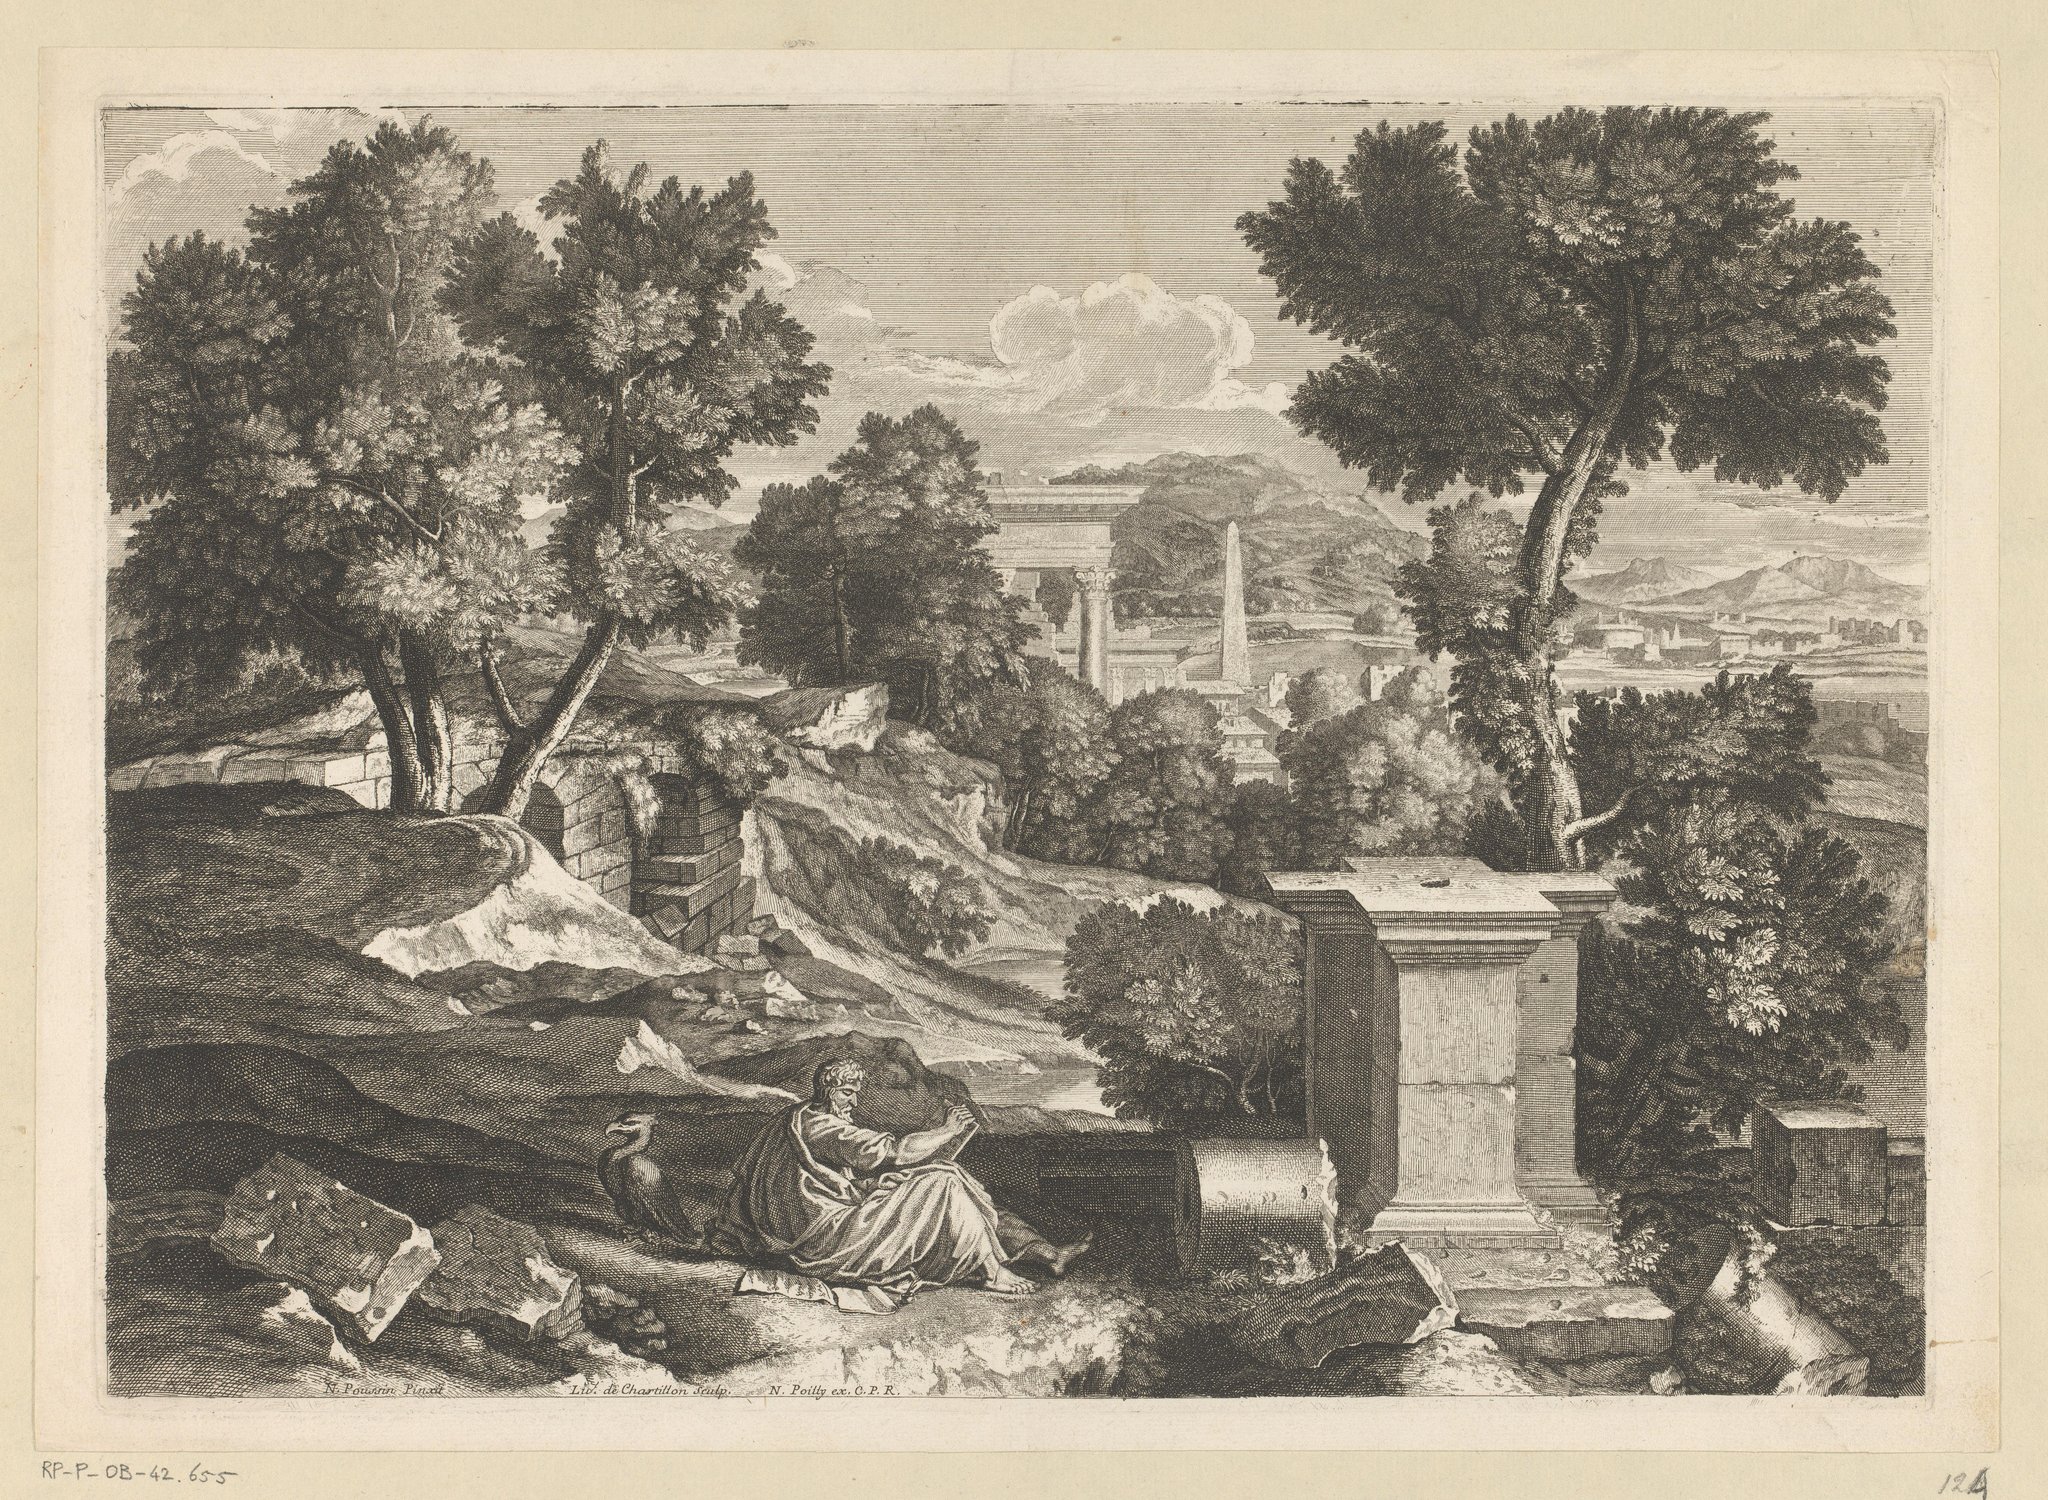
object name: print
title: Suite de six Paysages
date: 1649-1696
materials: paper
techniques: etching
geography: france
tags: landscape with ruins, life and acts of john the evangelist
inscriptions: collector's mark: Lugt 240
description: Maakt deel uit van een zesdelige serie met landschappen.